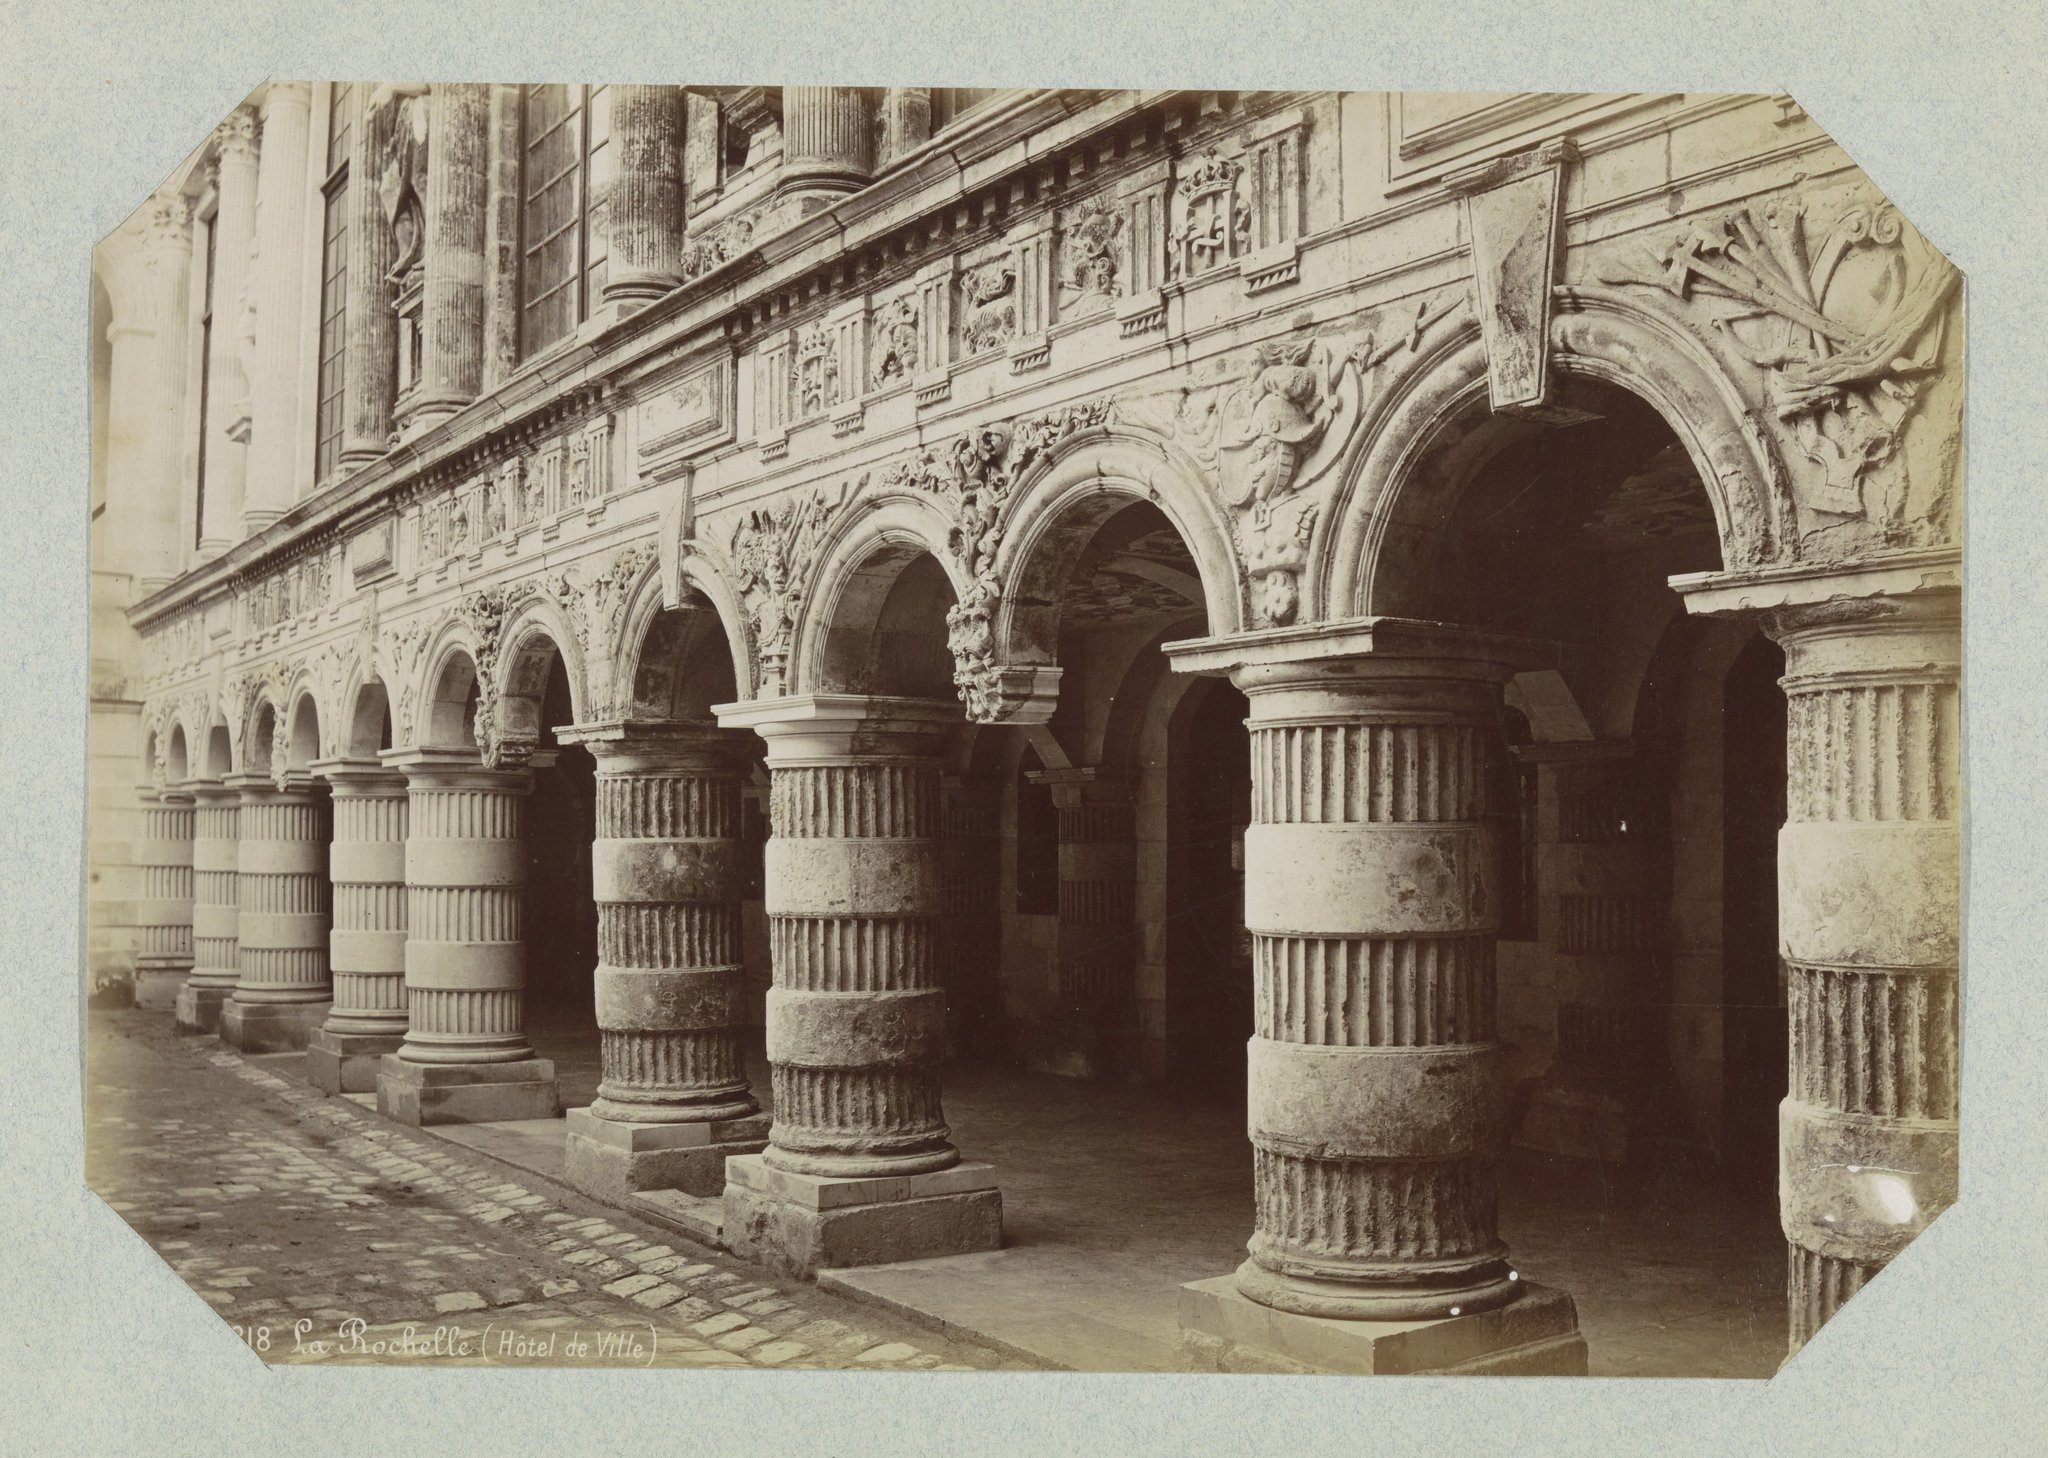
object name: photograph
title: Zuilengalerij in het stadhuis van La Rochelle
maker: séraphin-médéric mieusement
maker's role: fotograaf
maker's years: 1840-1905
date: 1880-1900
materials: photographic support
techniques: albumen print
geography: la rochelle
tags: colonnade, column, pillar ~ architecture, townhall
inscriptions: number: ‘[...]18’, inscription: ‘Monuments Historiques’, name: ‘Mieusement photographe’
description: Onderdeel van Fotoalbum met opnames van monumenten in Frankrijk.